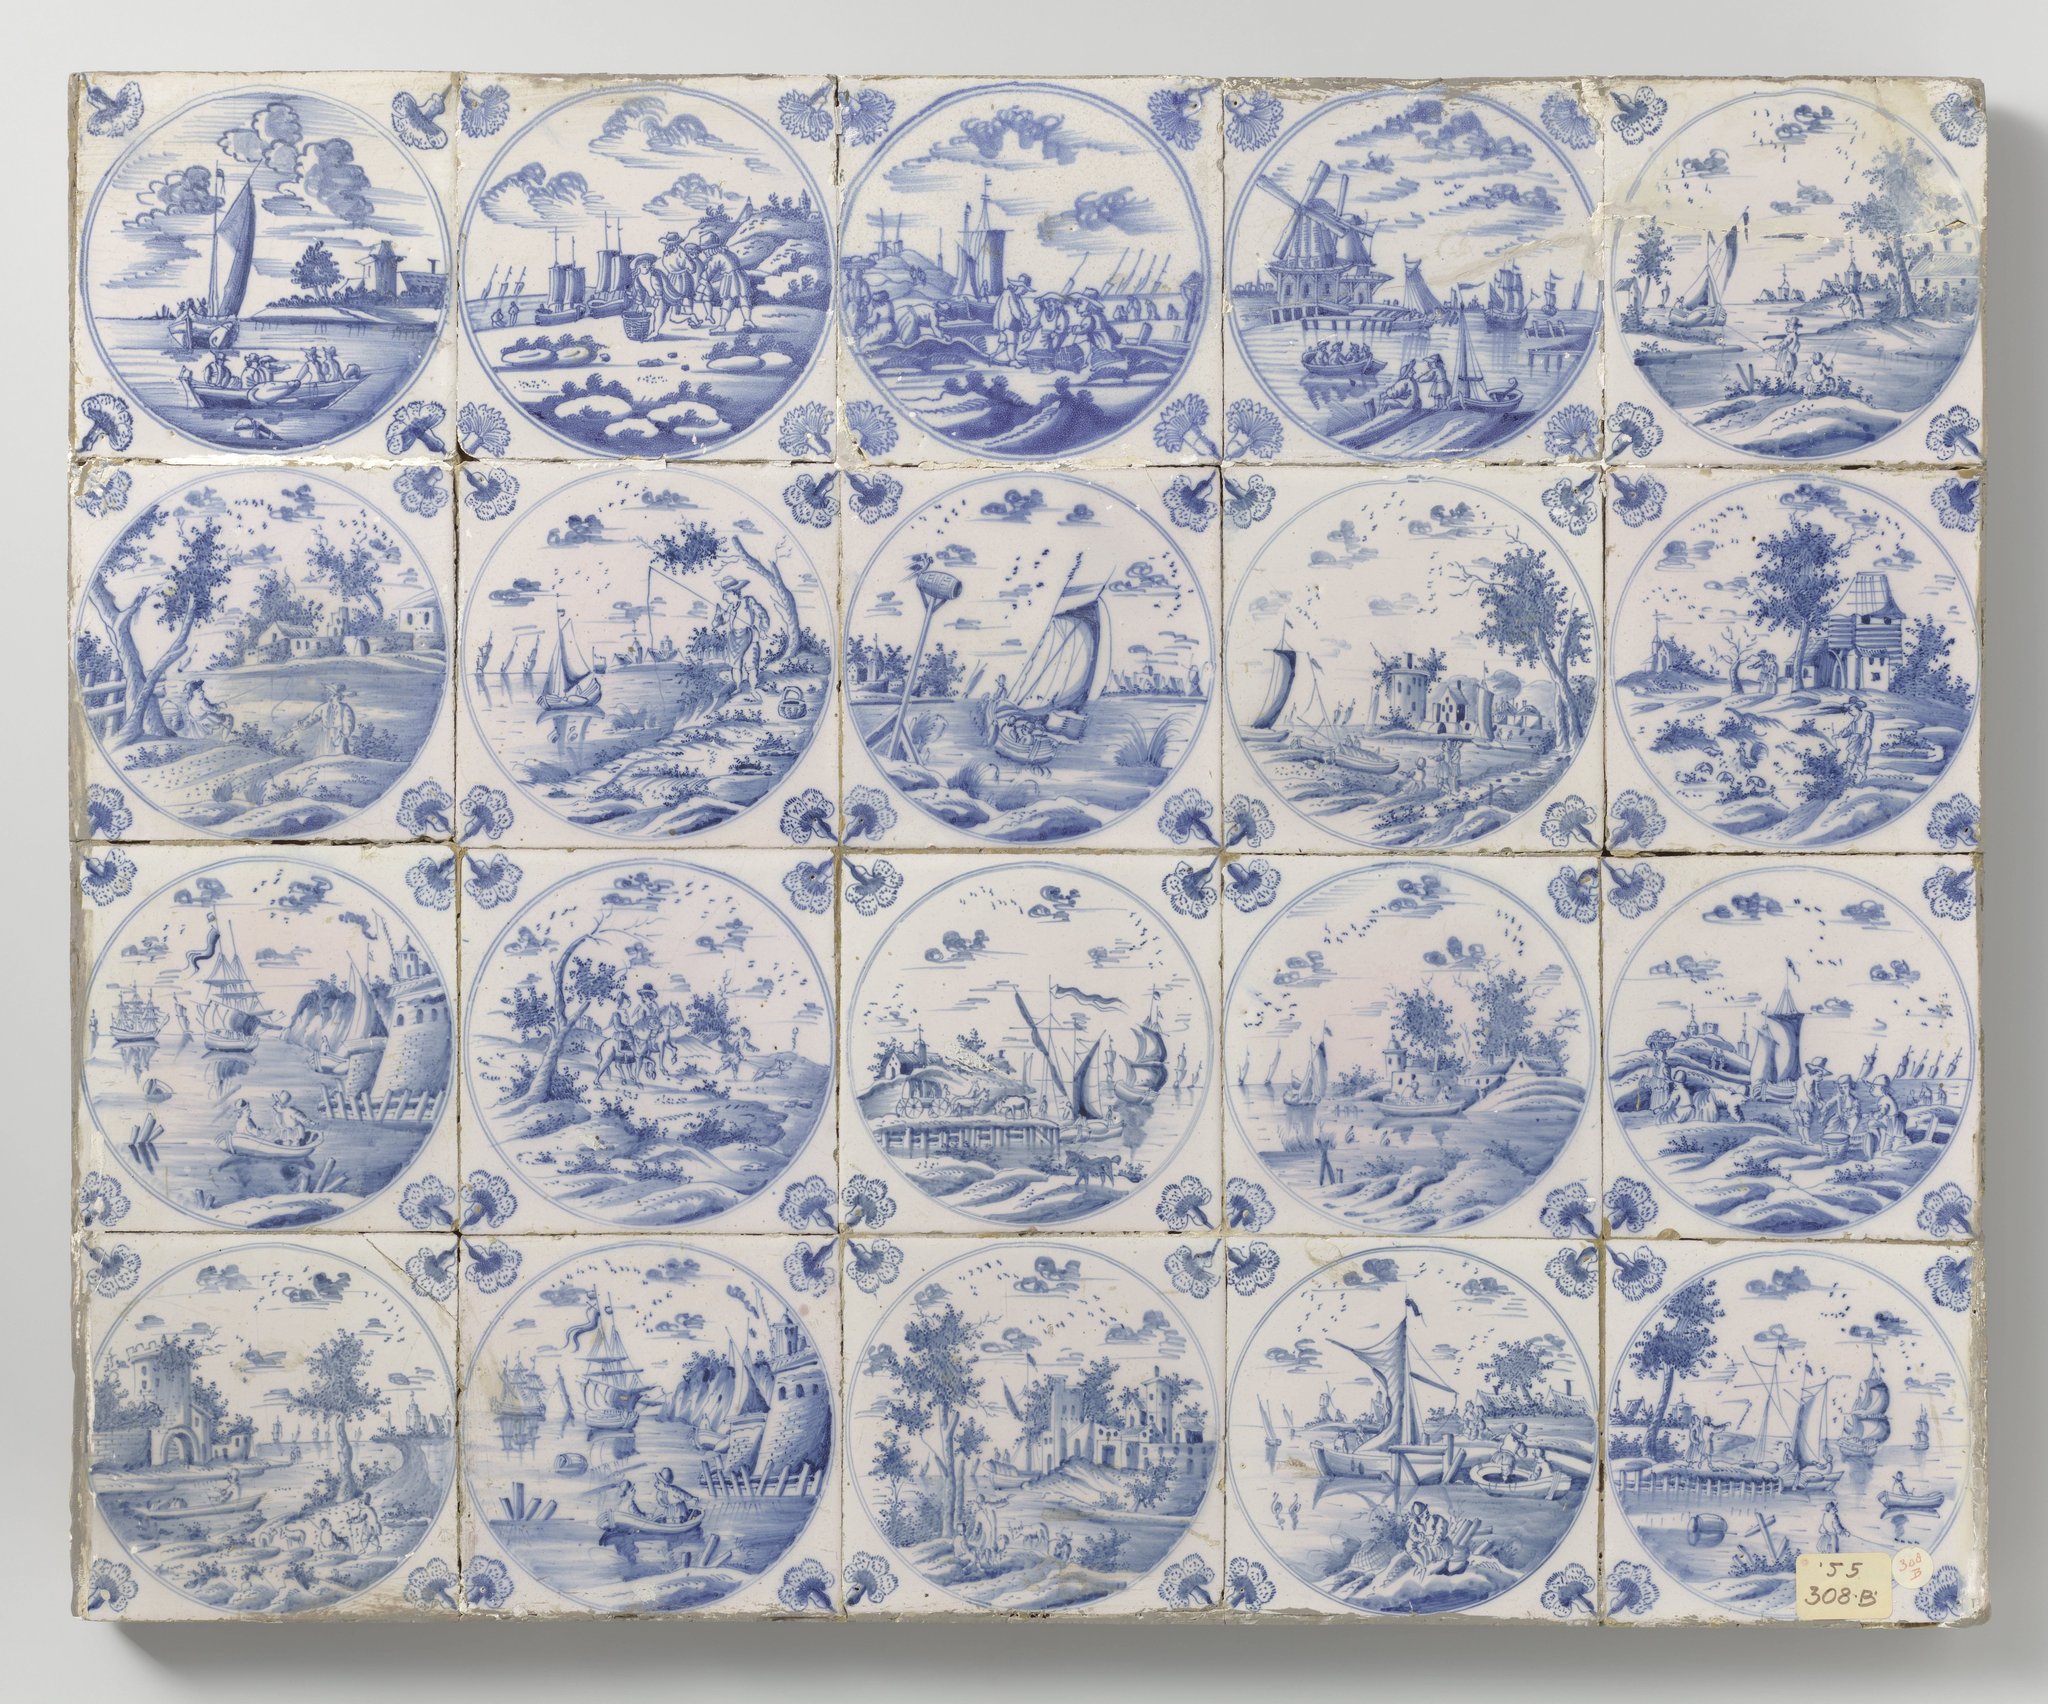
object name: tile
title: Veld van twintig tegels met landschappen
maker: Anonymous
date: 1740-1800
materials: earthenware, glaze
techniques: maiolica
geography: netherlands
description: Veld van twintig tegels (4 x 5) met blauw geschilderde landschappen in een cirkel. In de hoeken, een anjer.